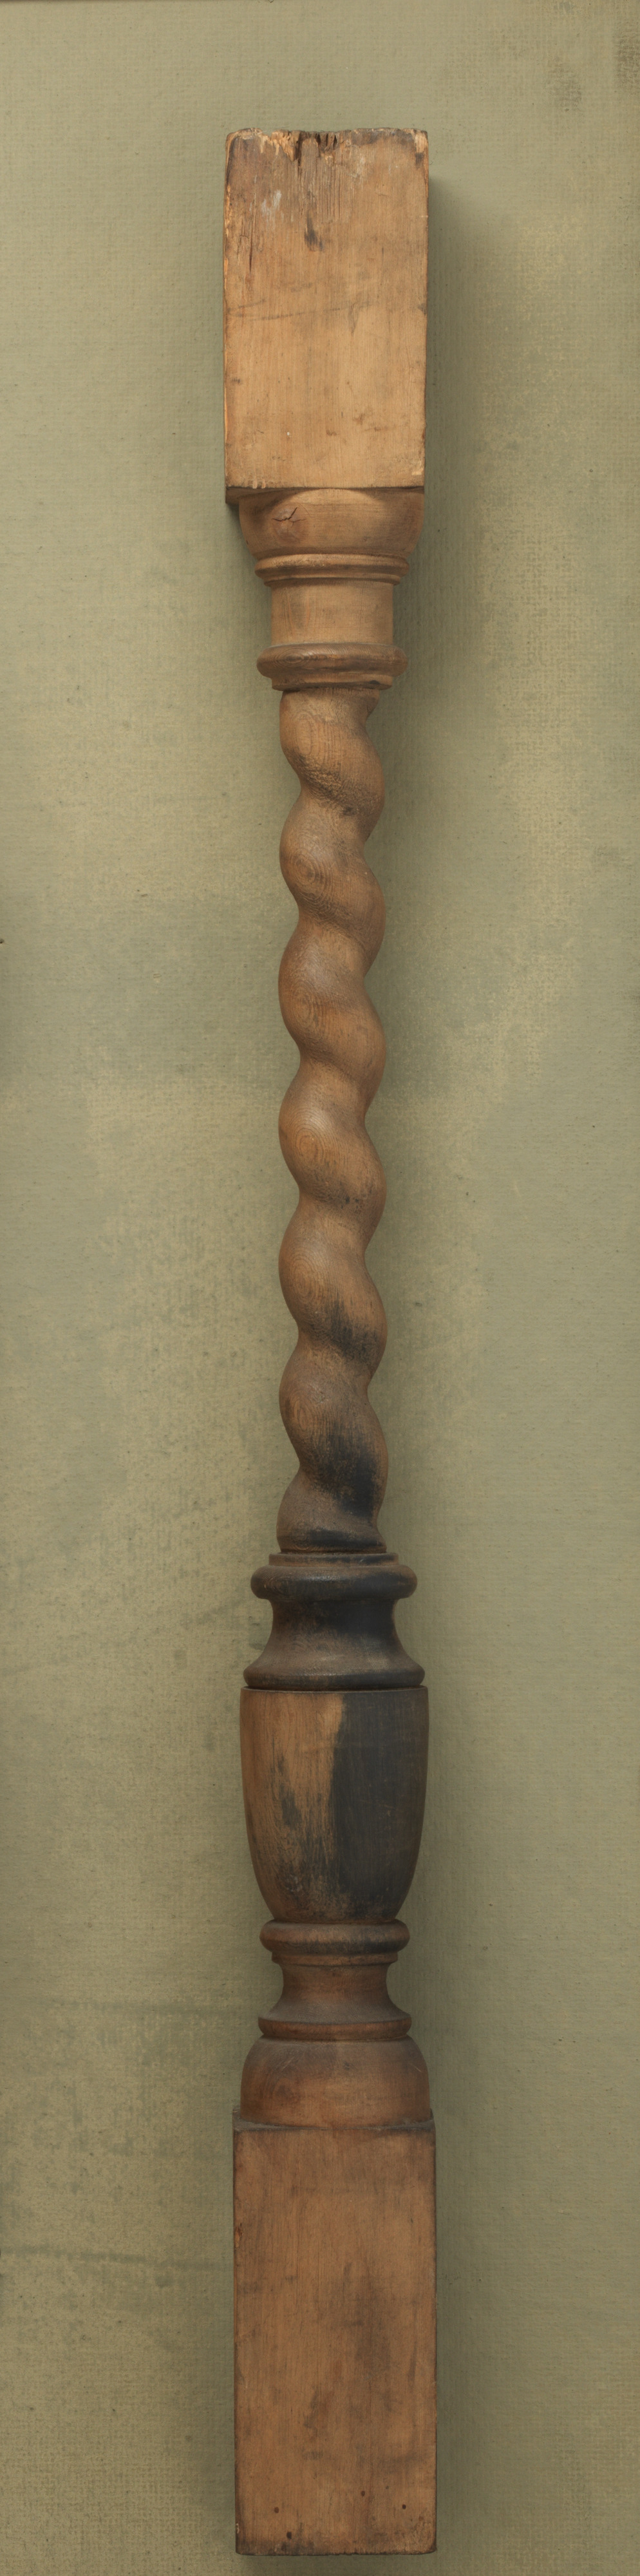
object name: baluster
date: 1667-1733